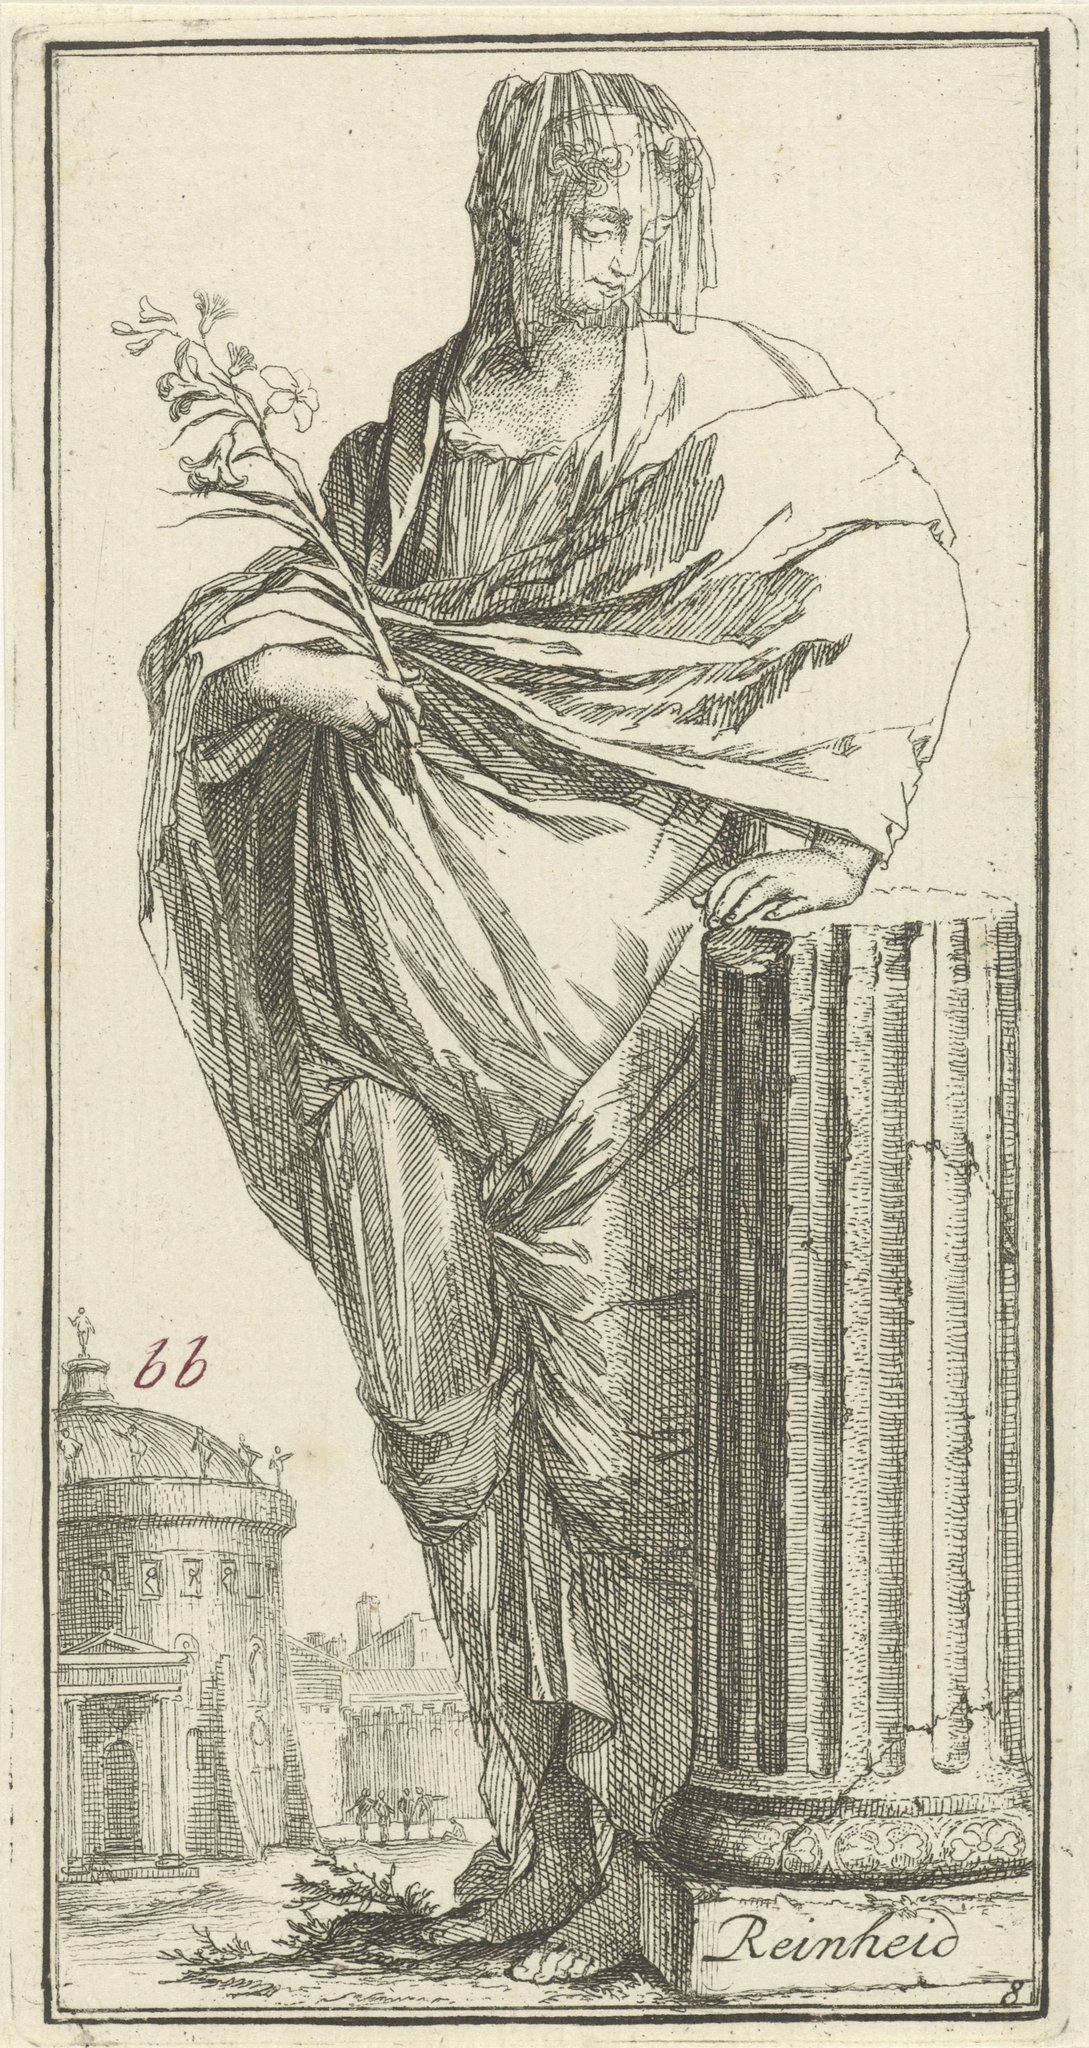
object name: print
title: Een-en-veertigh stuks, verscheydene Sinnebeelden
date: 1710-1719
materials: paper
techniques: engraving, etching, pen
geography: amsterdam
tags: 'castità ', 'pudicitia', 'vergogna honesta' (ripa), flowers: lily (+ plants used symbolically)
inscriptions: collector's mark: Lugt 2228, inscription: ‘bb’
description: Een gesluierde vrouwfiguur met in haar rechterhand een lelie en haar linkerhand rustend op een zuil als de gepersonifieerde Reinheid. Op de achtergrond een klassiek bouwwerk. Prent uit een serie van 41 zinnebeelden.